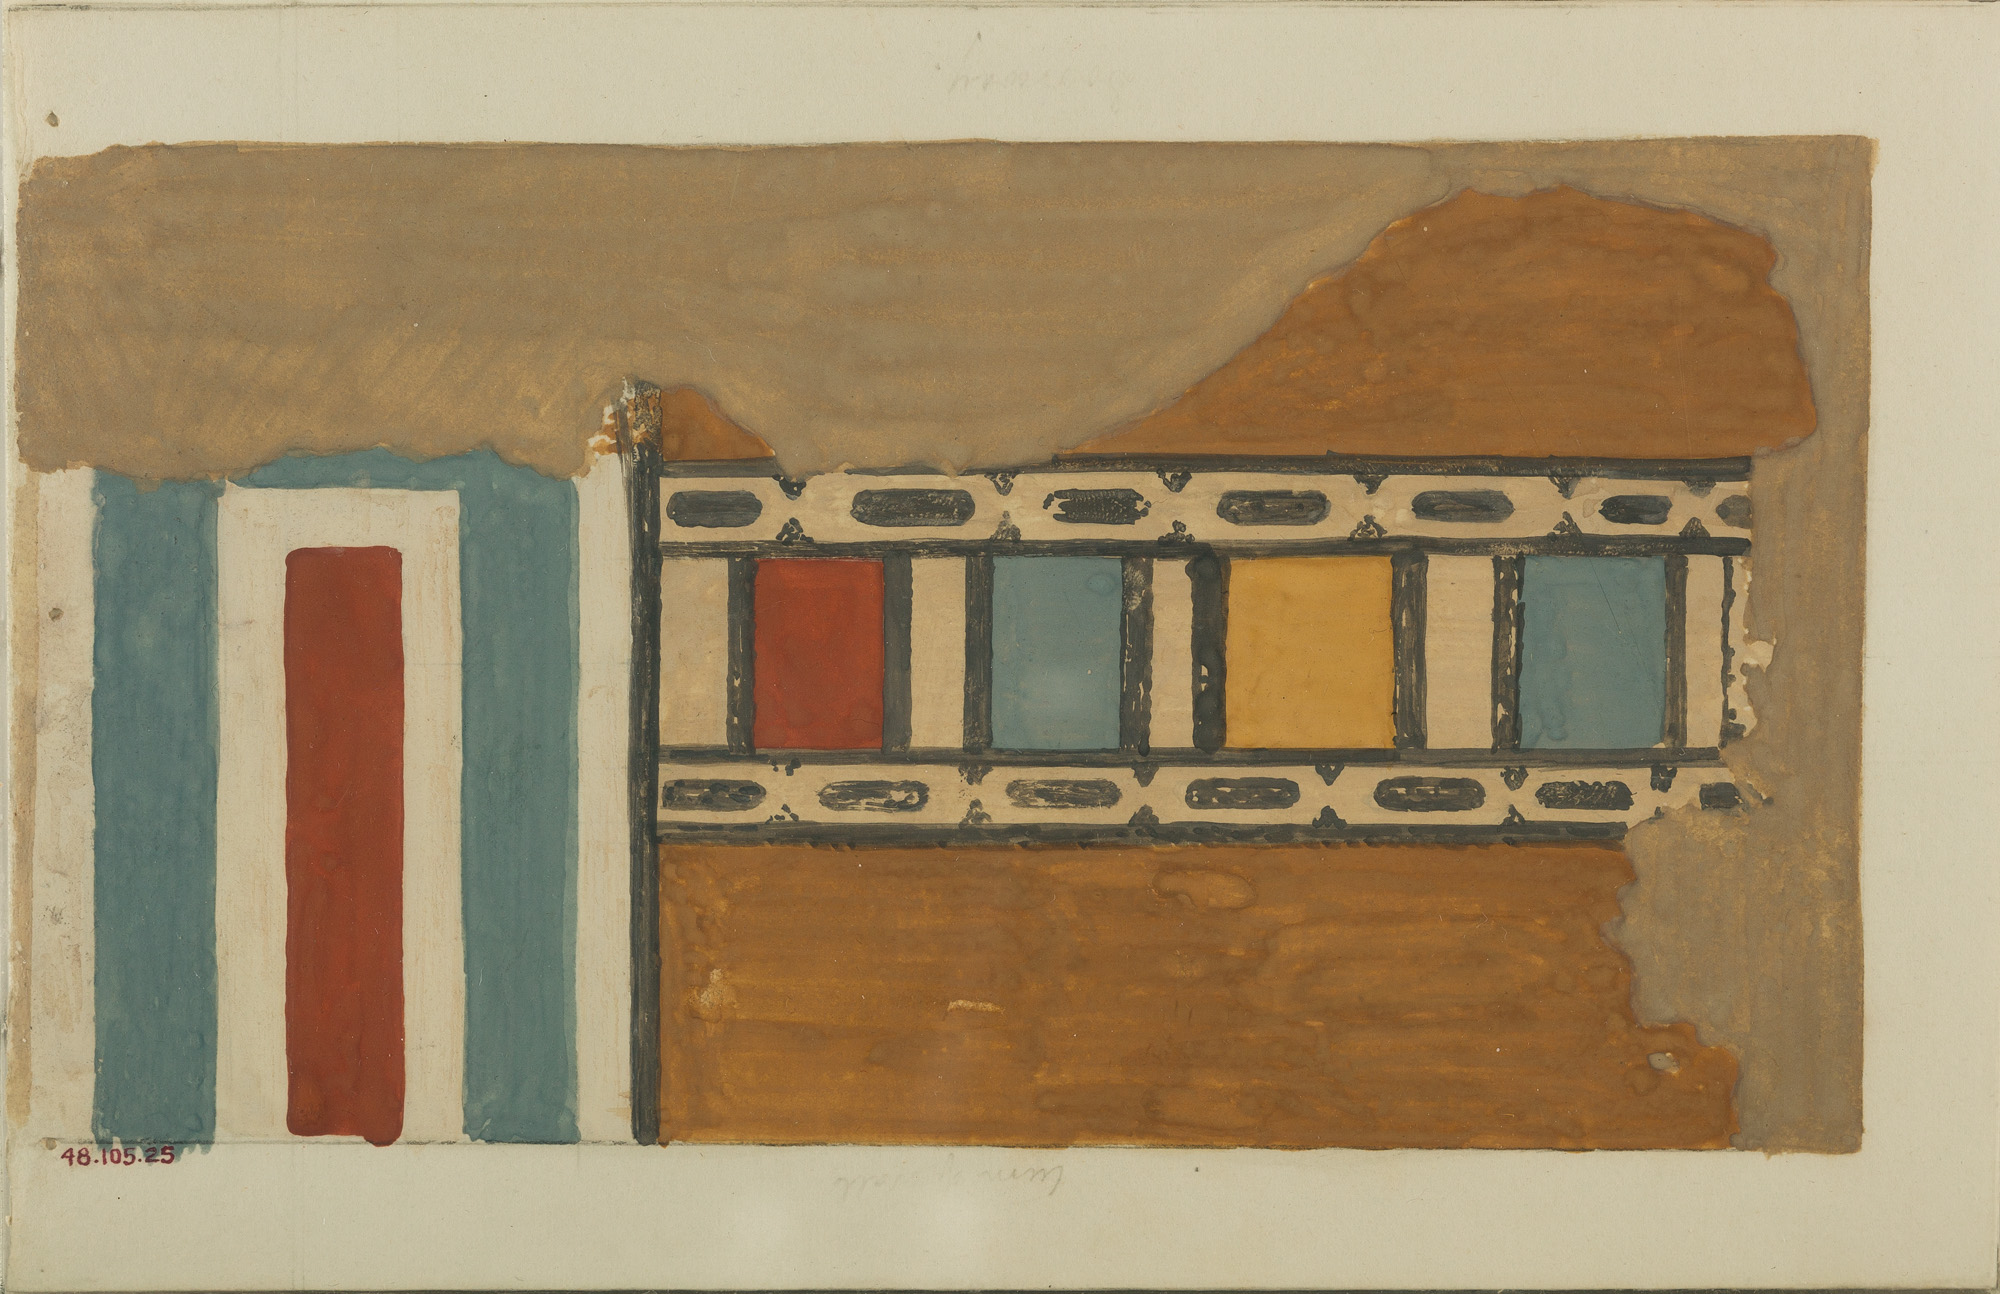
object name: facsimile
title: Facsimile, Winlock's Tomb 5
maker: unknown copyist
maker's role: artist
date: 1567-1482 BCE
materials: paper, paint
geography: egypt